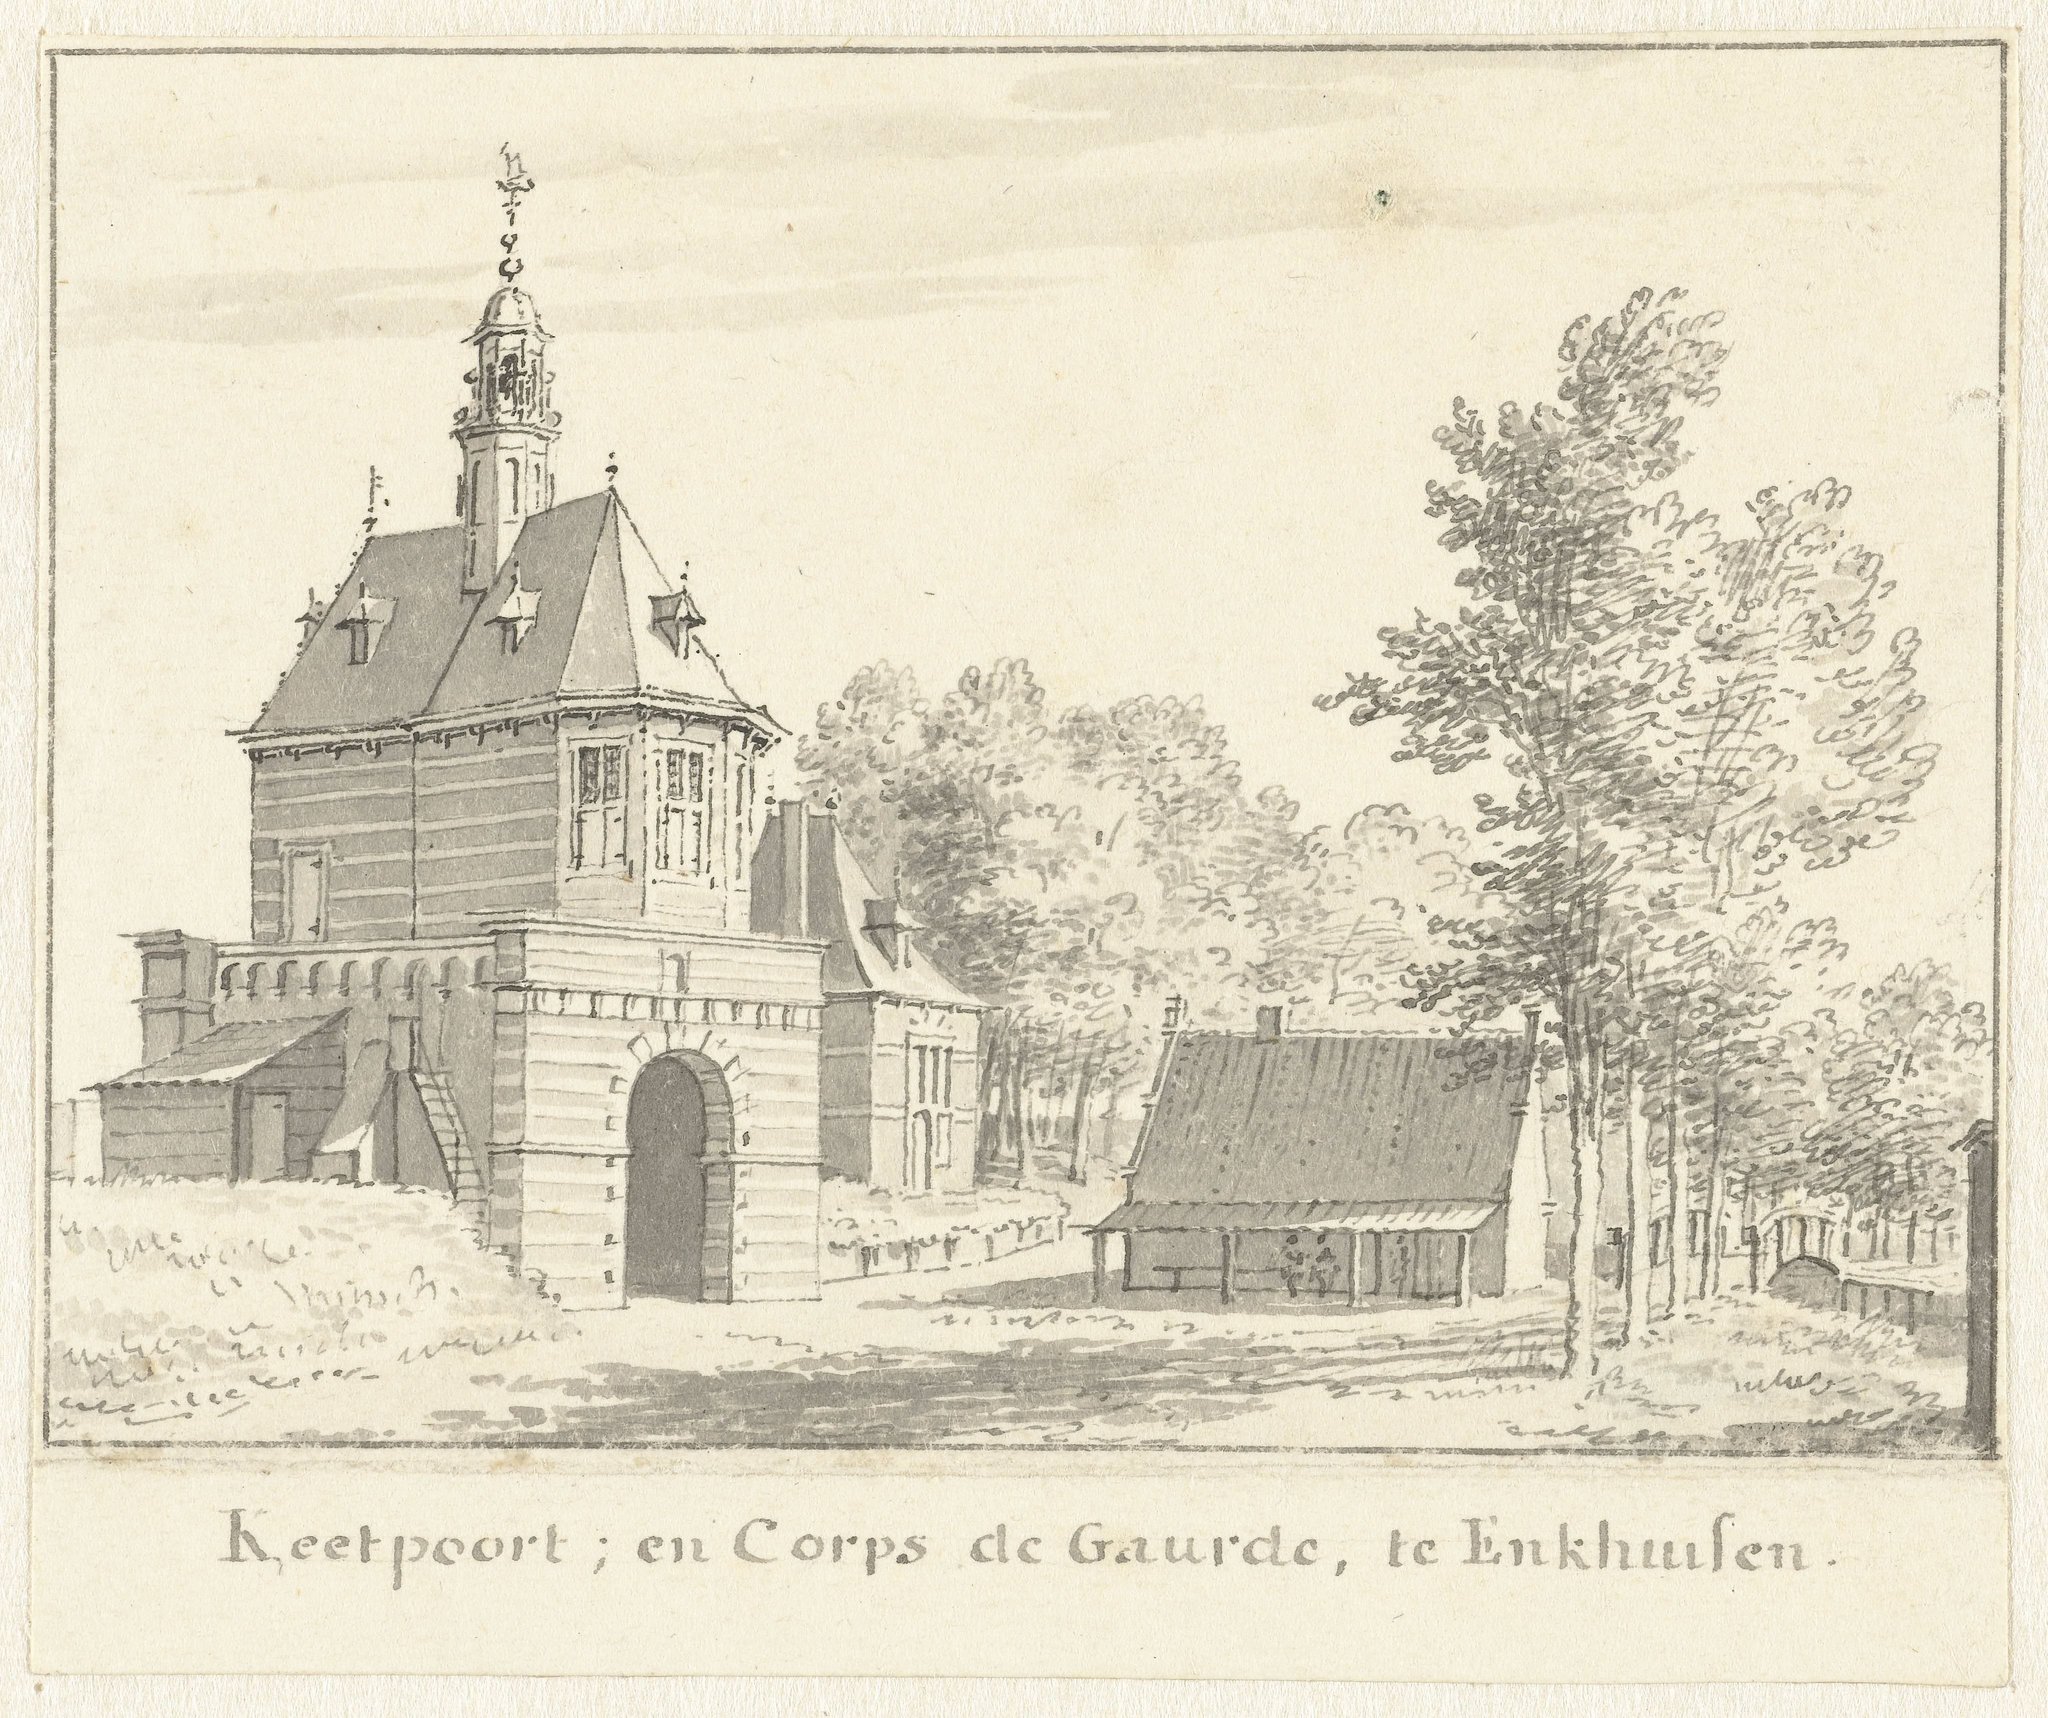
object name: drawing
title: De Keetpoort te Enkhuizen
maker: cornelis pronk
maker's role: draughtsman, painter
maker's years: 1691-1759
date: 1701-1759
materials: ink, paper, pencil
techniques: brush, pen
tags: city-gate, enkhuizen